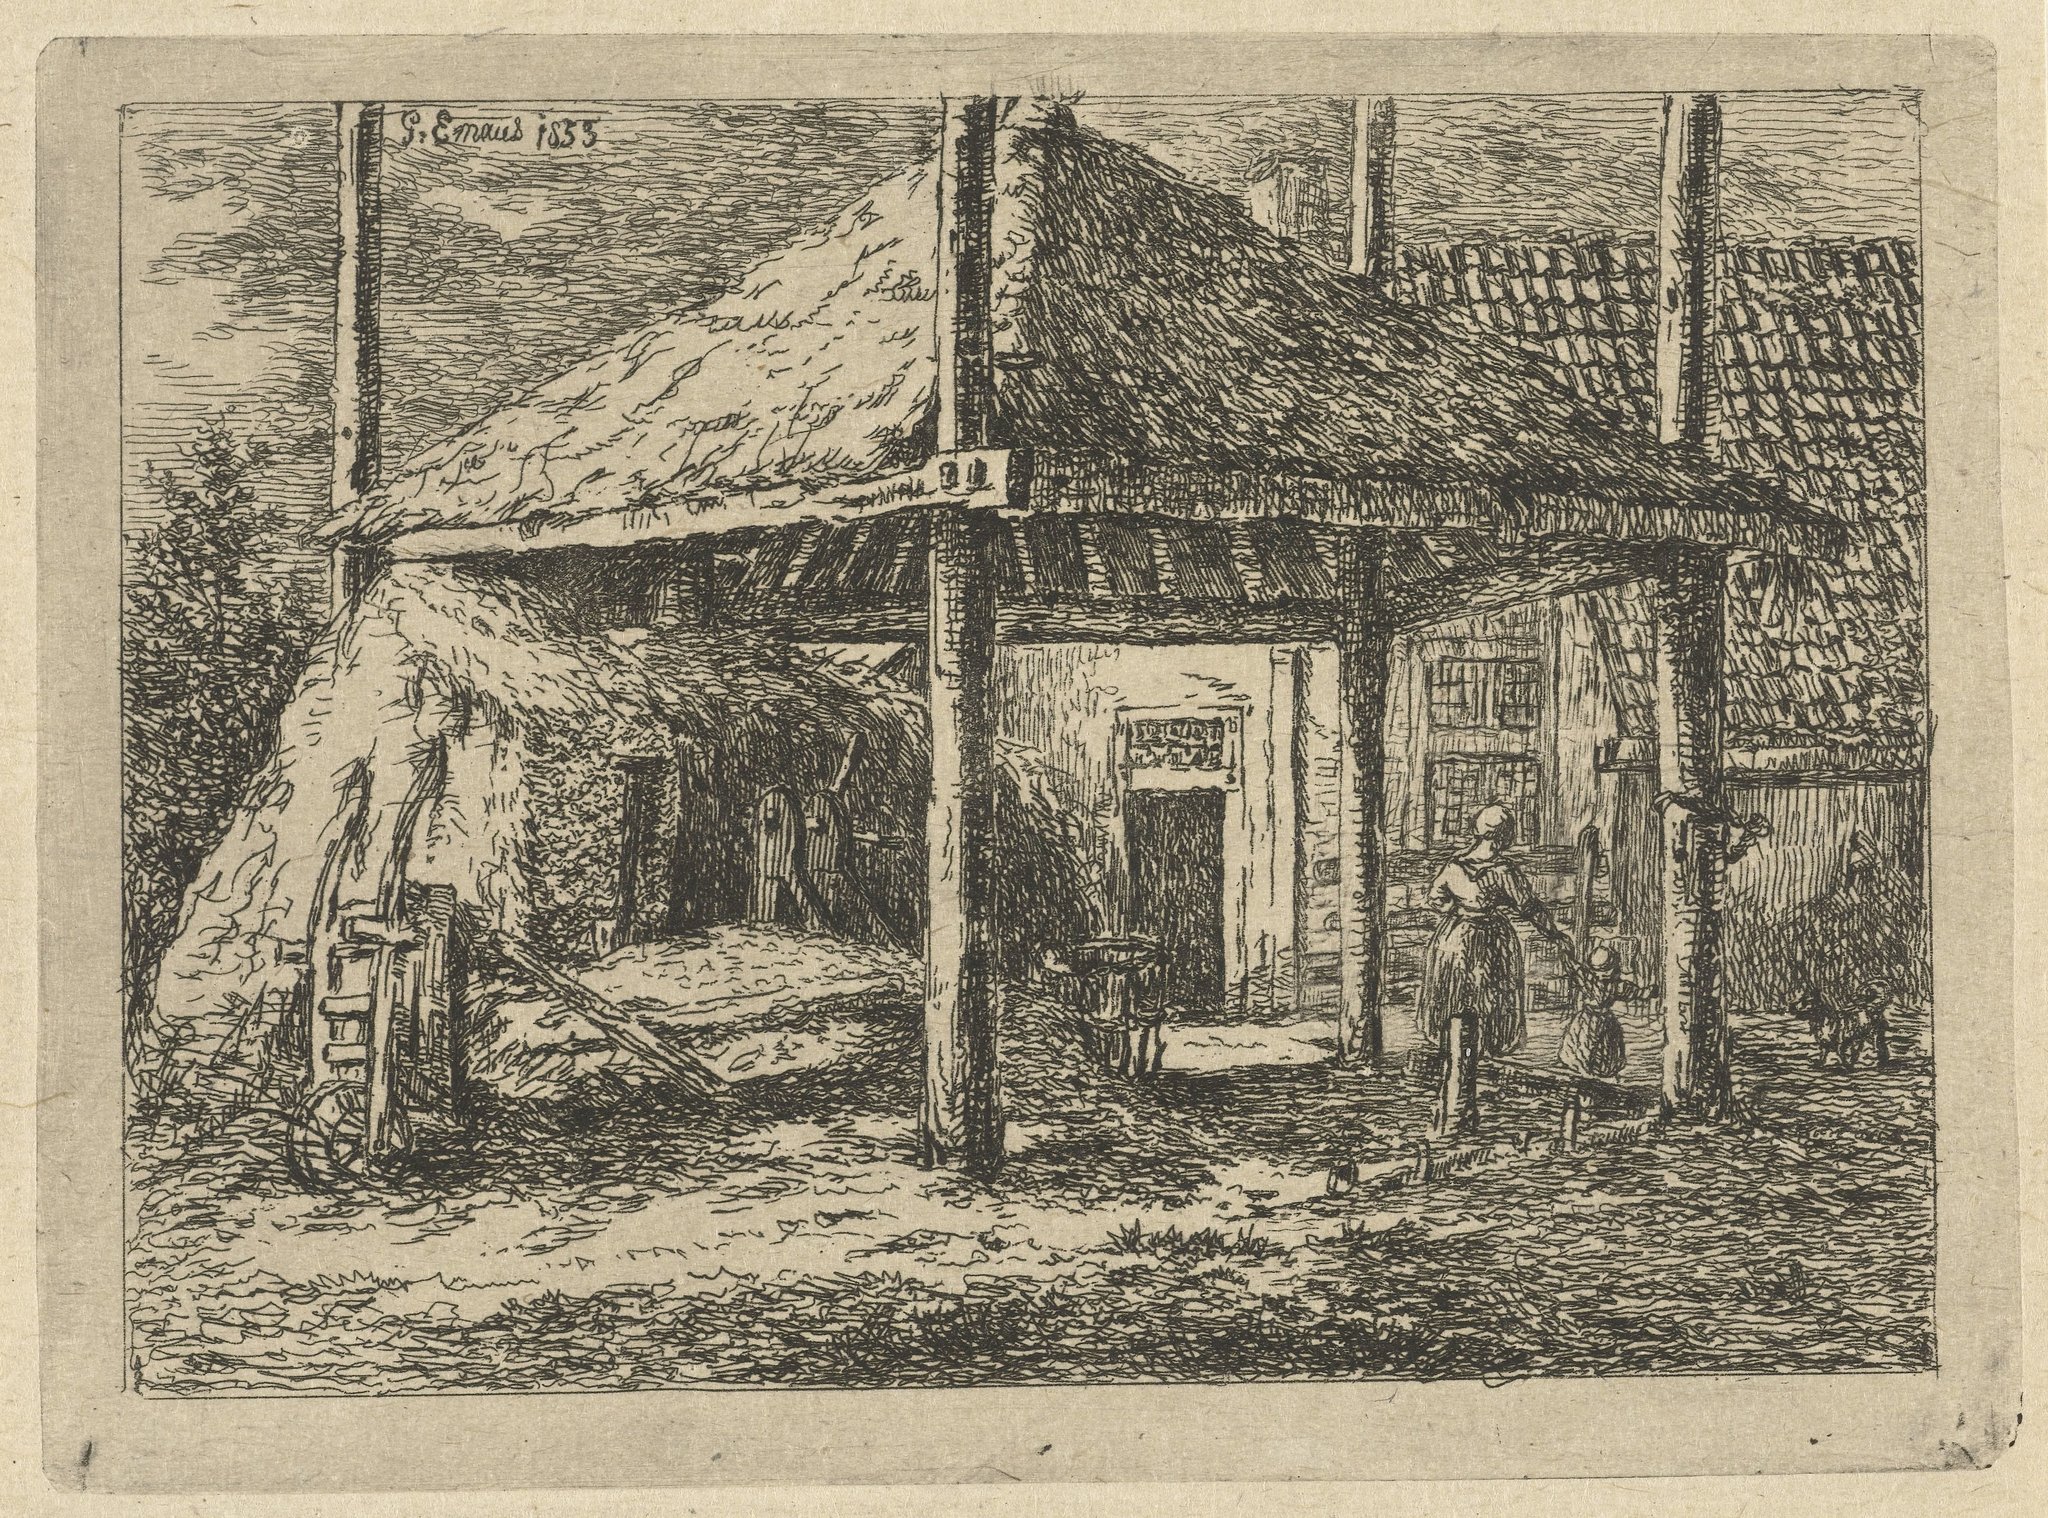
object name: print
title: Dak van een hooischelf te Pernis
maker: gerardus emaus de micault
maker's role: draughtsman, print maker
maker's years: 1798-1863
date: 1853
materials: paper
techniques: etching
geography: netherlands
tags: hay-stack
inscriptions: collector's mark: Lugt 2228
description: Tussen een hooiberg en een boerderij staan een moeder en kind bij een hond.